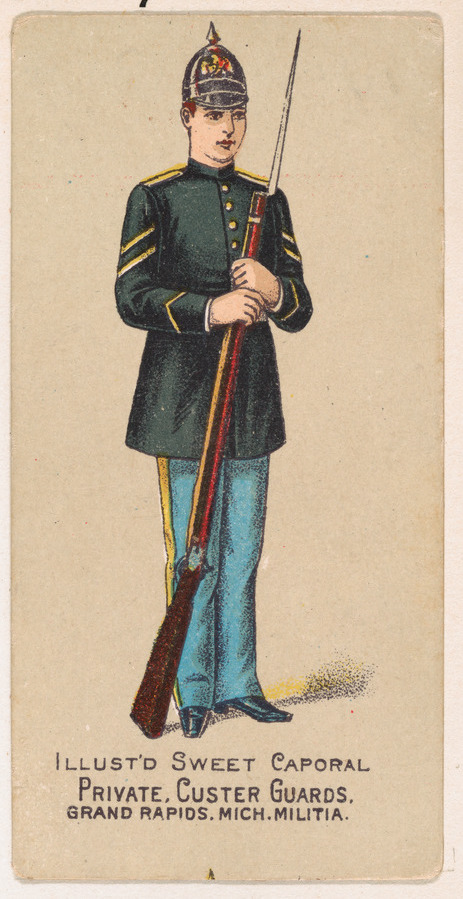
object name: print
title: Private, Custer Guards, Grand Rapids, Michigan Militia, from the Military Series (N224) issued by Kinney Tobacco Company to promote Sweet Caporal Cigarettes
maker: kinney brothers tobacco company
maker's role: publisher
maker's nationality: american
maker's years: 1869-2011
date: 1888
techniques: color lithograph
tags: military,soldiers,firearms,men